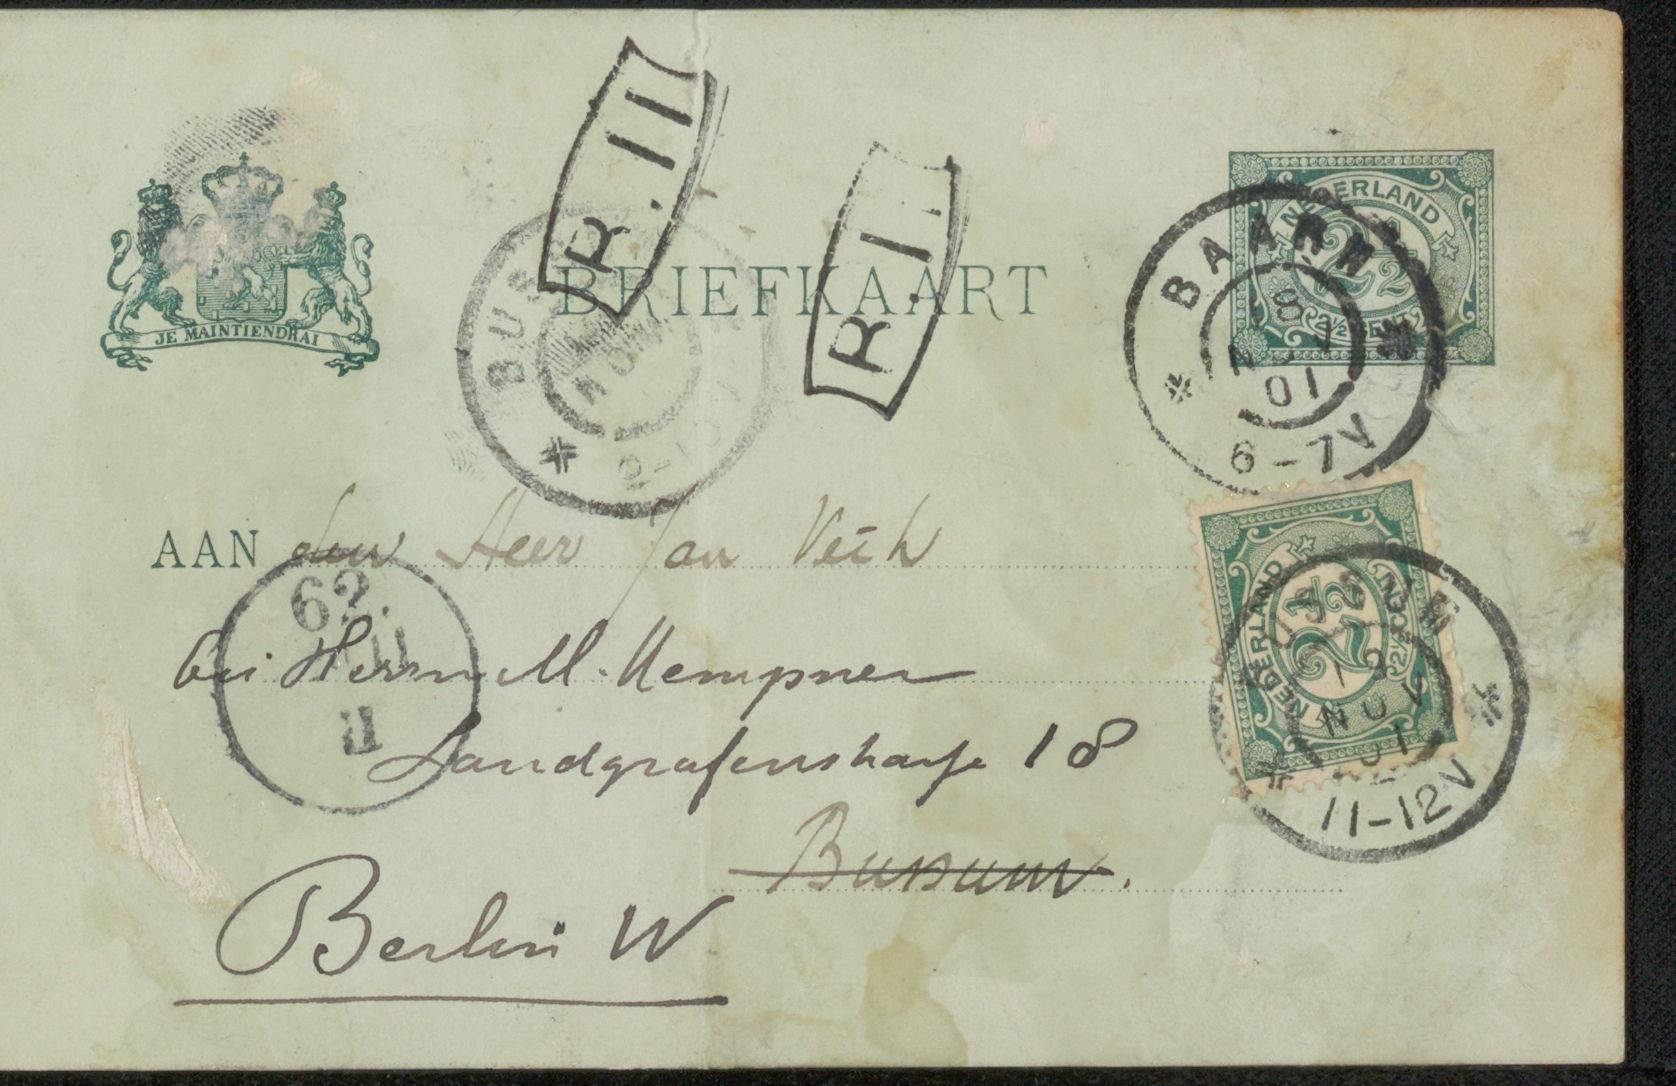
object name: postcard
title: Briefkaart aan Jan Veth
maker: karel johan lodewijk alberdingk thijm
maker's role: criticus, prozaschrijver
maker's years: 1864-1952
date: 1901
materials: cardboard, ink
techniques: pen, writing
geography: baarn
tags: dordrecht, painter, print maker, draughtsman, designer, jan veth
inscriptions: collector's mark: ‘RPK’